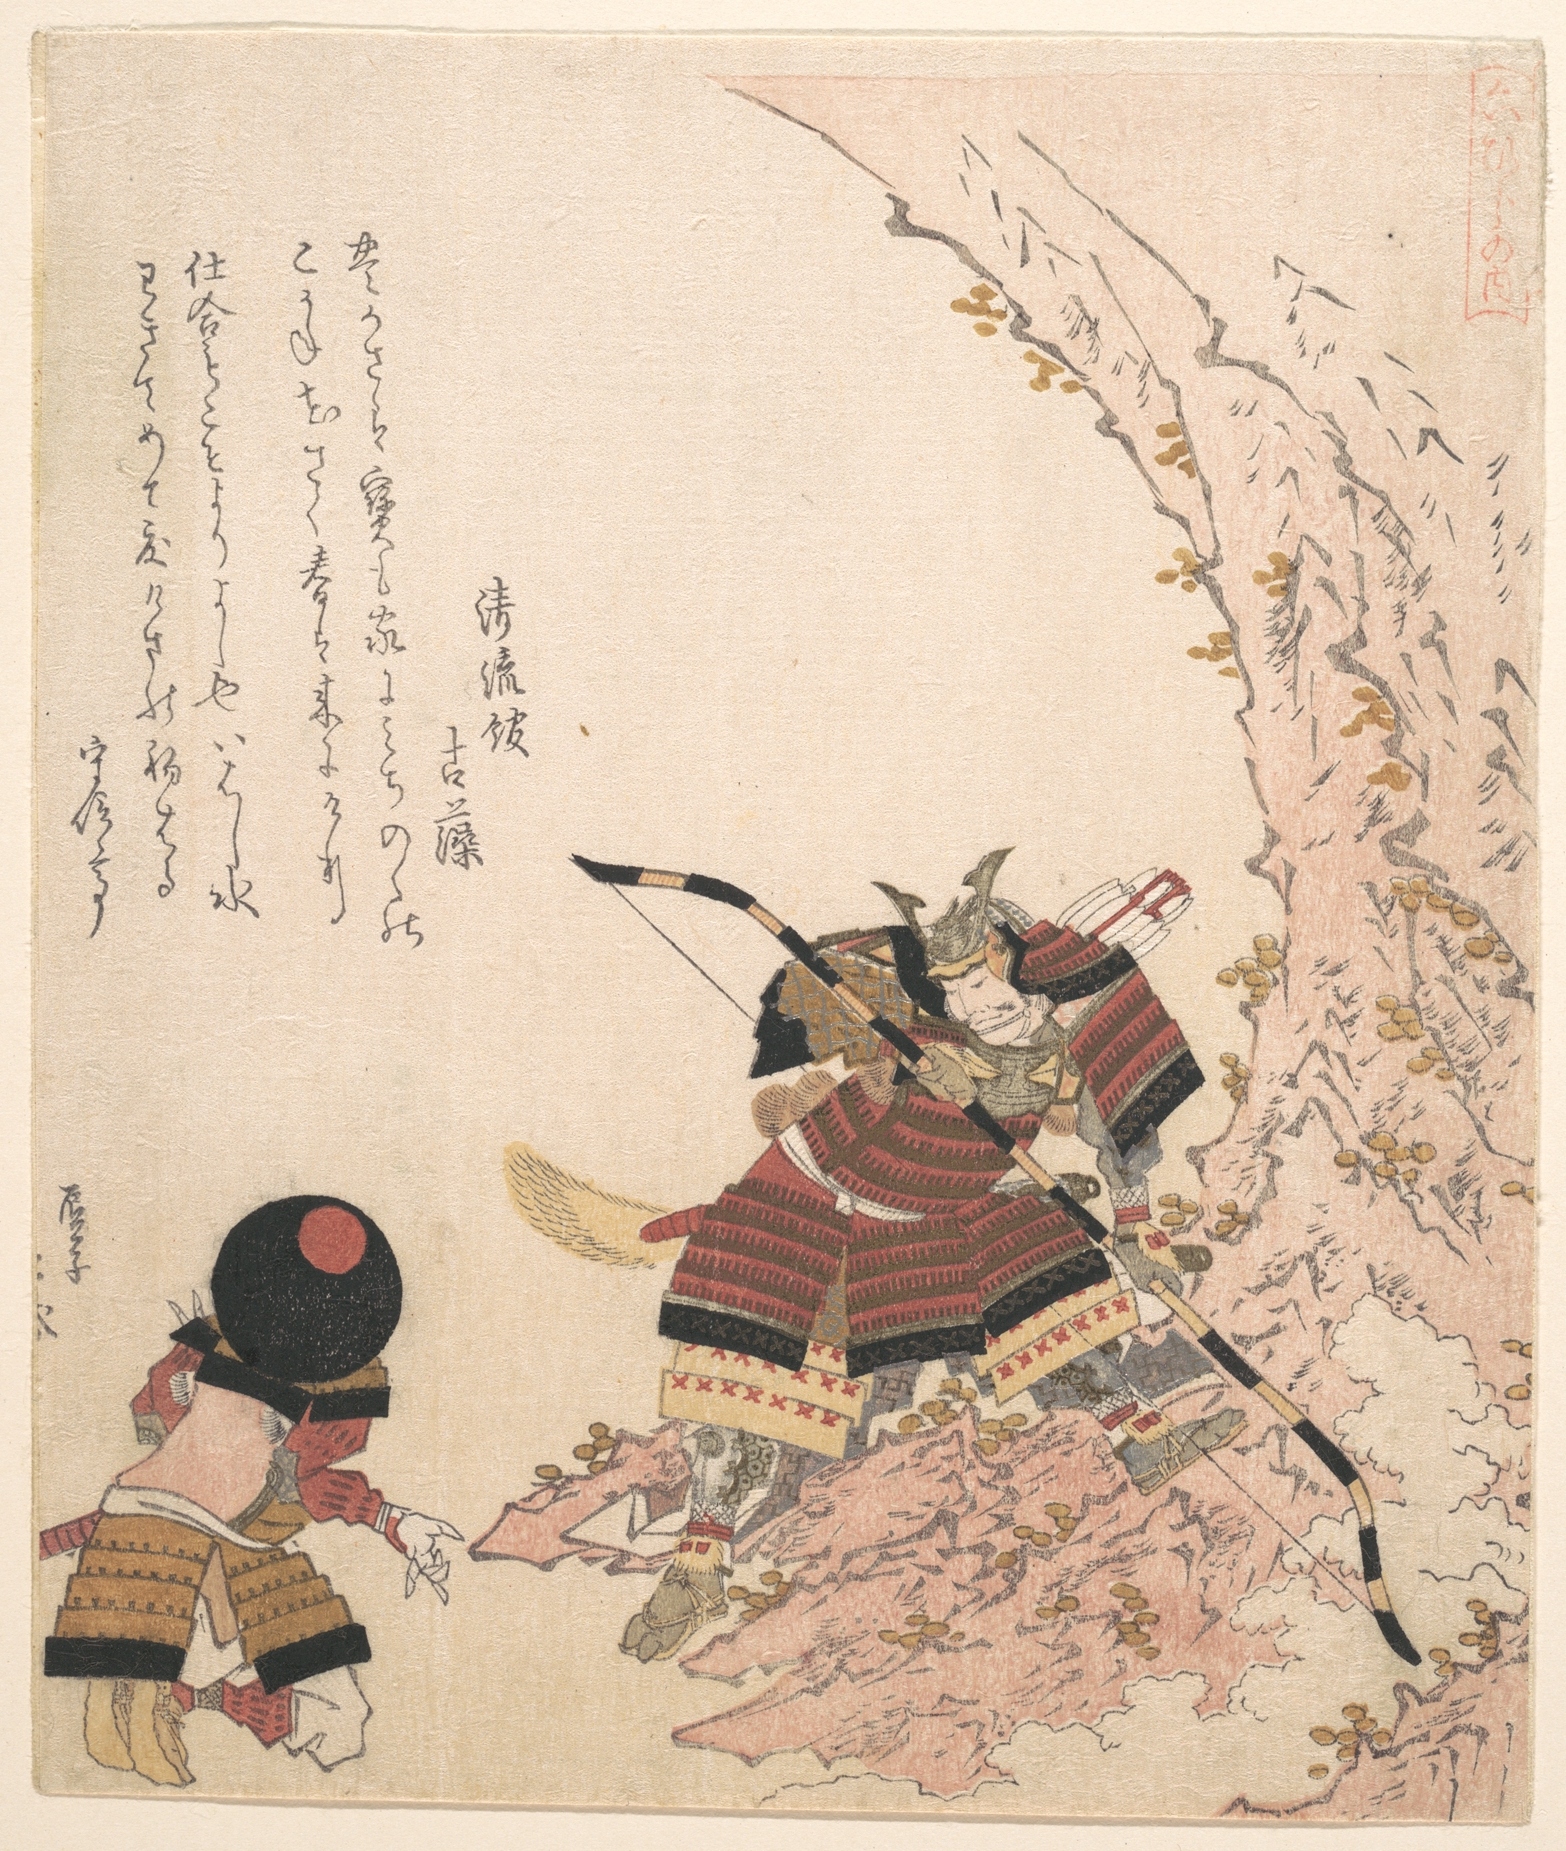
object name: print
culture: japanese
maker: totoya hokkei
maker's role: artist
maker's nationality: japanese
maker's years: 1780-1850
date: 1780-1850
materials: ink, paper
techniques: surimono, woodblock print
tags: bow and arrow,men